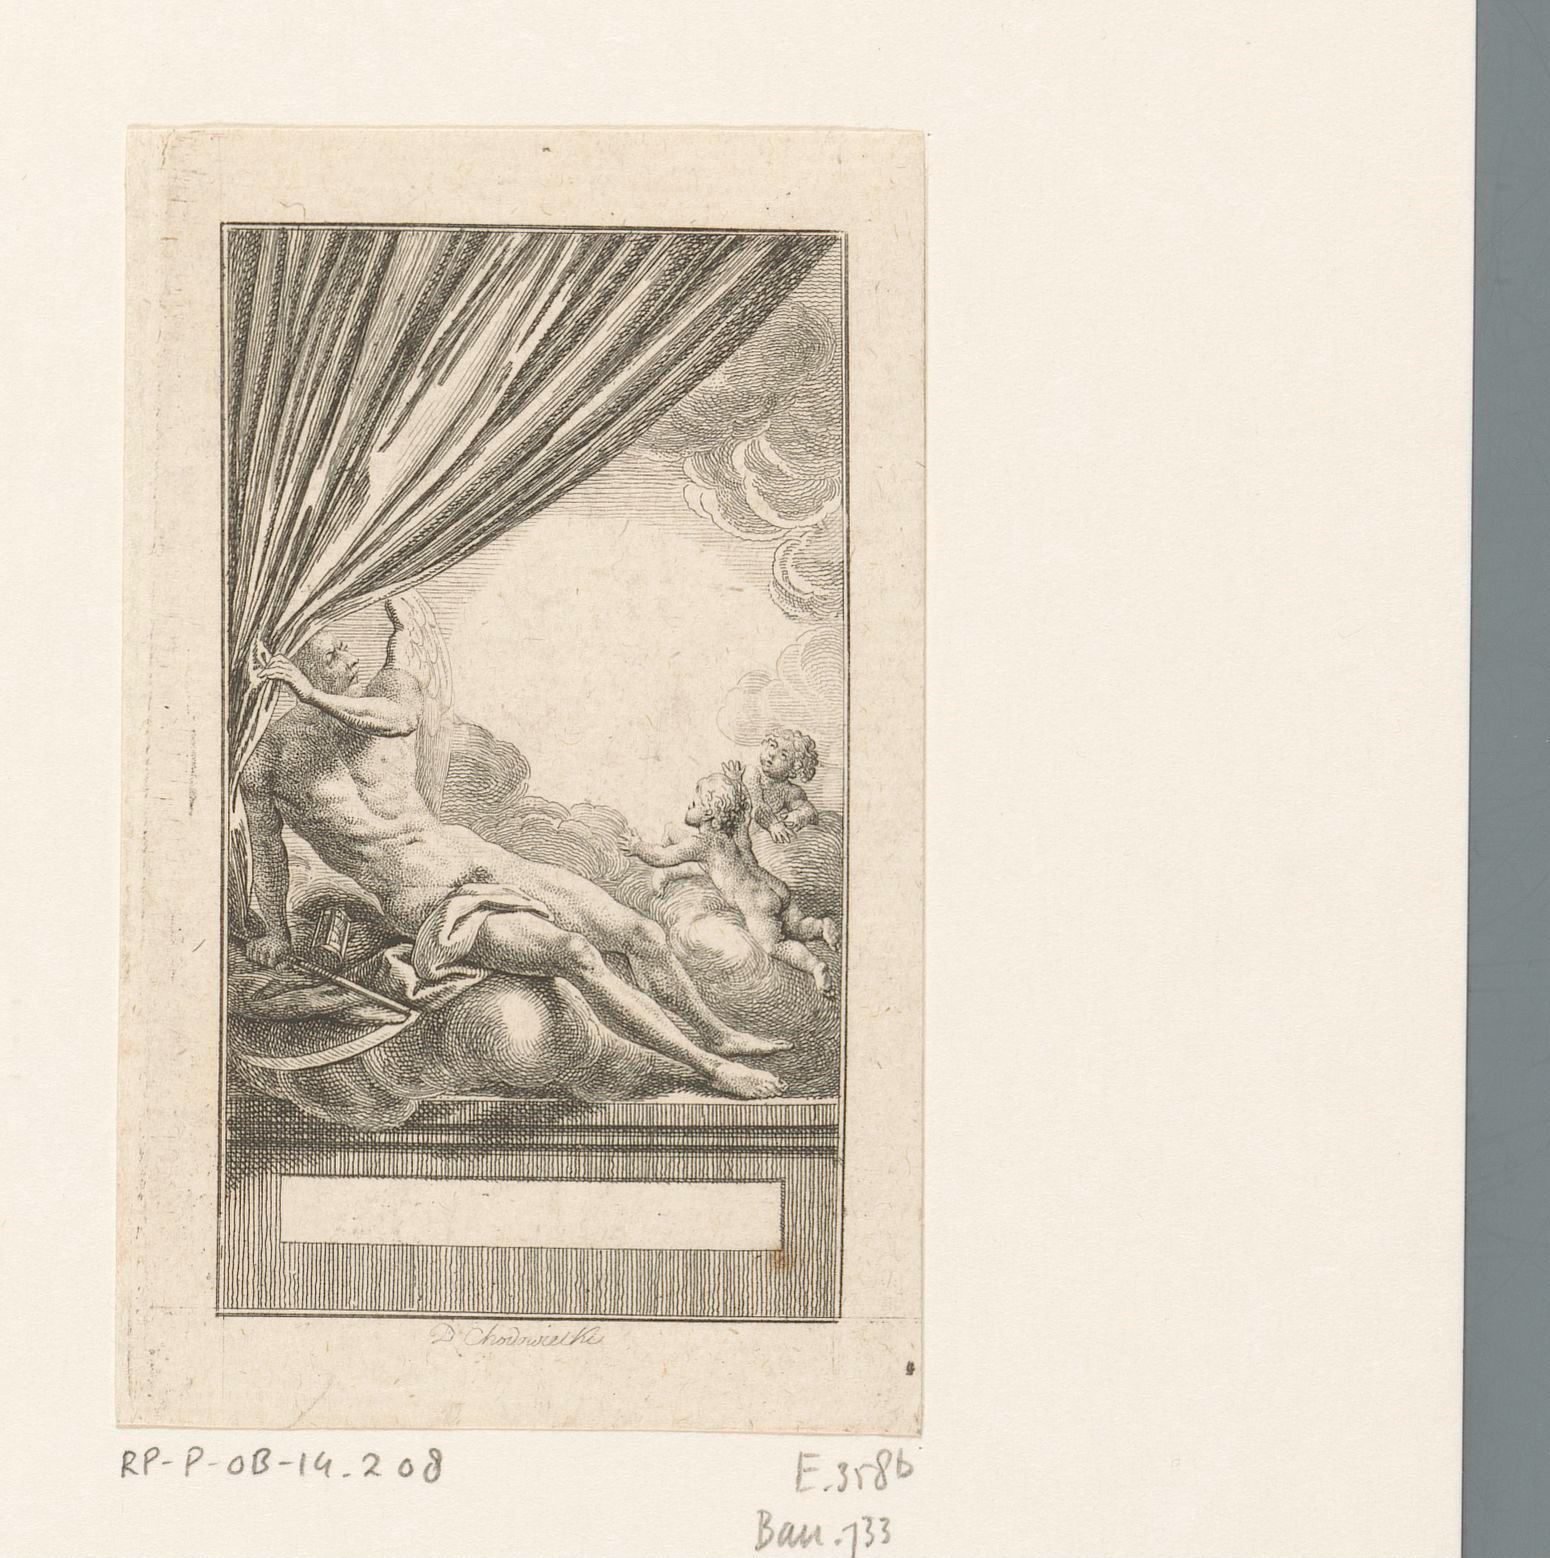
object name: print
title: Kronos trekt een doek opzij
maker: daniel nikolaus chodowiecki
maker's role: draughtsman, print maker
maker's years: 1726-1801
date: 1780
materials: paper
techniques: etching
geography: berlin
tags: (story of) saturn (cronus), cupids: 'amores', 'amoretti', 'putti'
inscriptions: collector's mark: Lugt 2228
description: Een latere staat van deze prent is ook gebruikt in: Almanac de Goettingue pour l'année 1781. Göttingen: Johann Christian Dieterich.